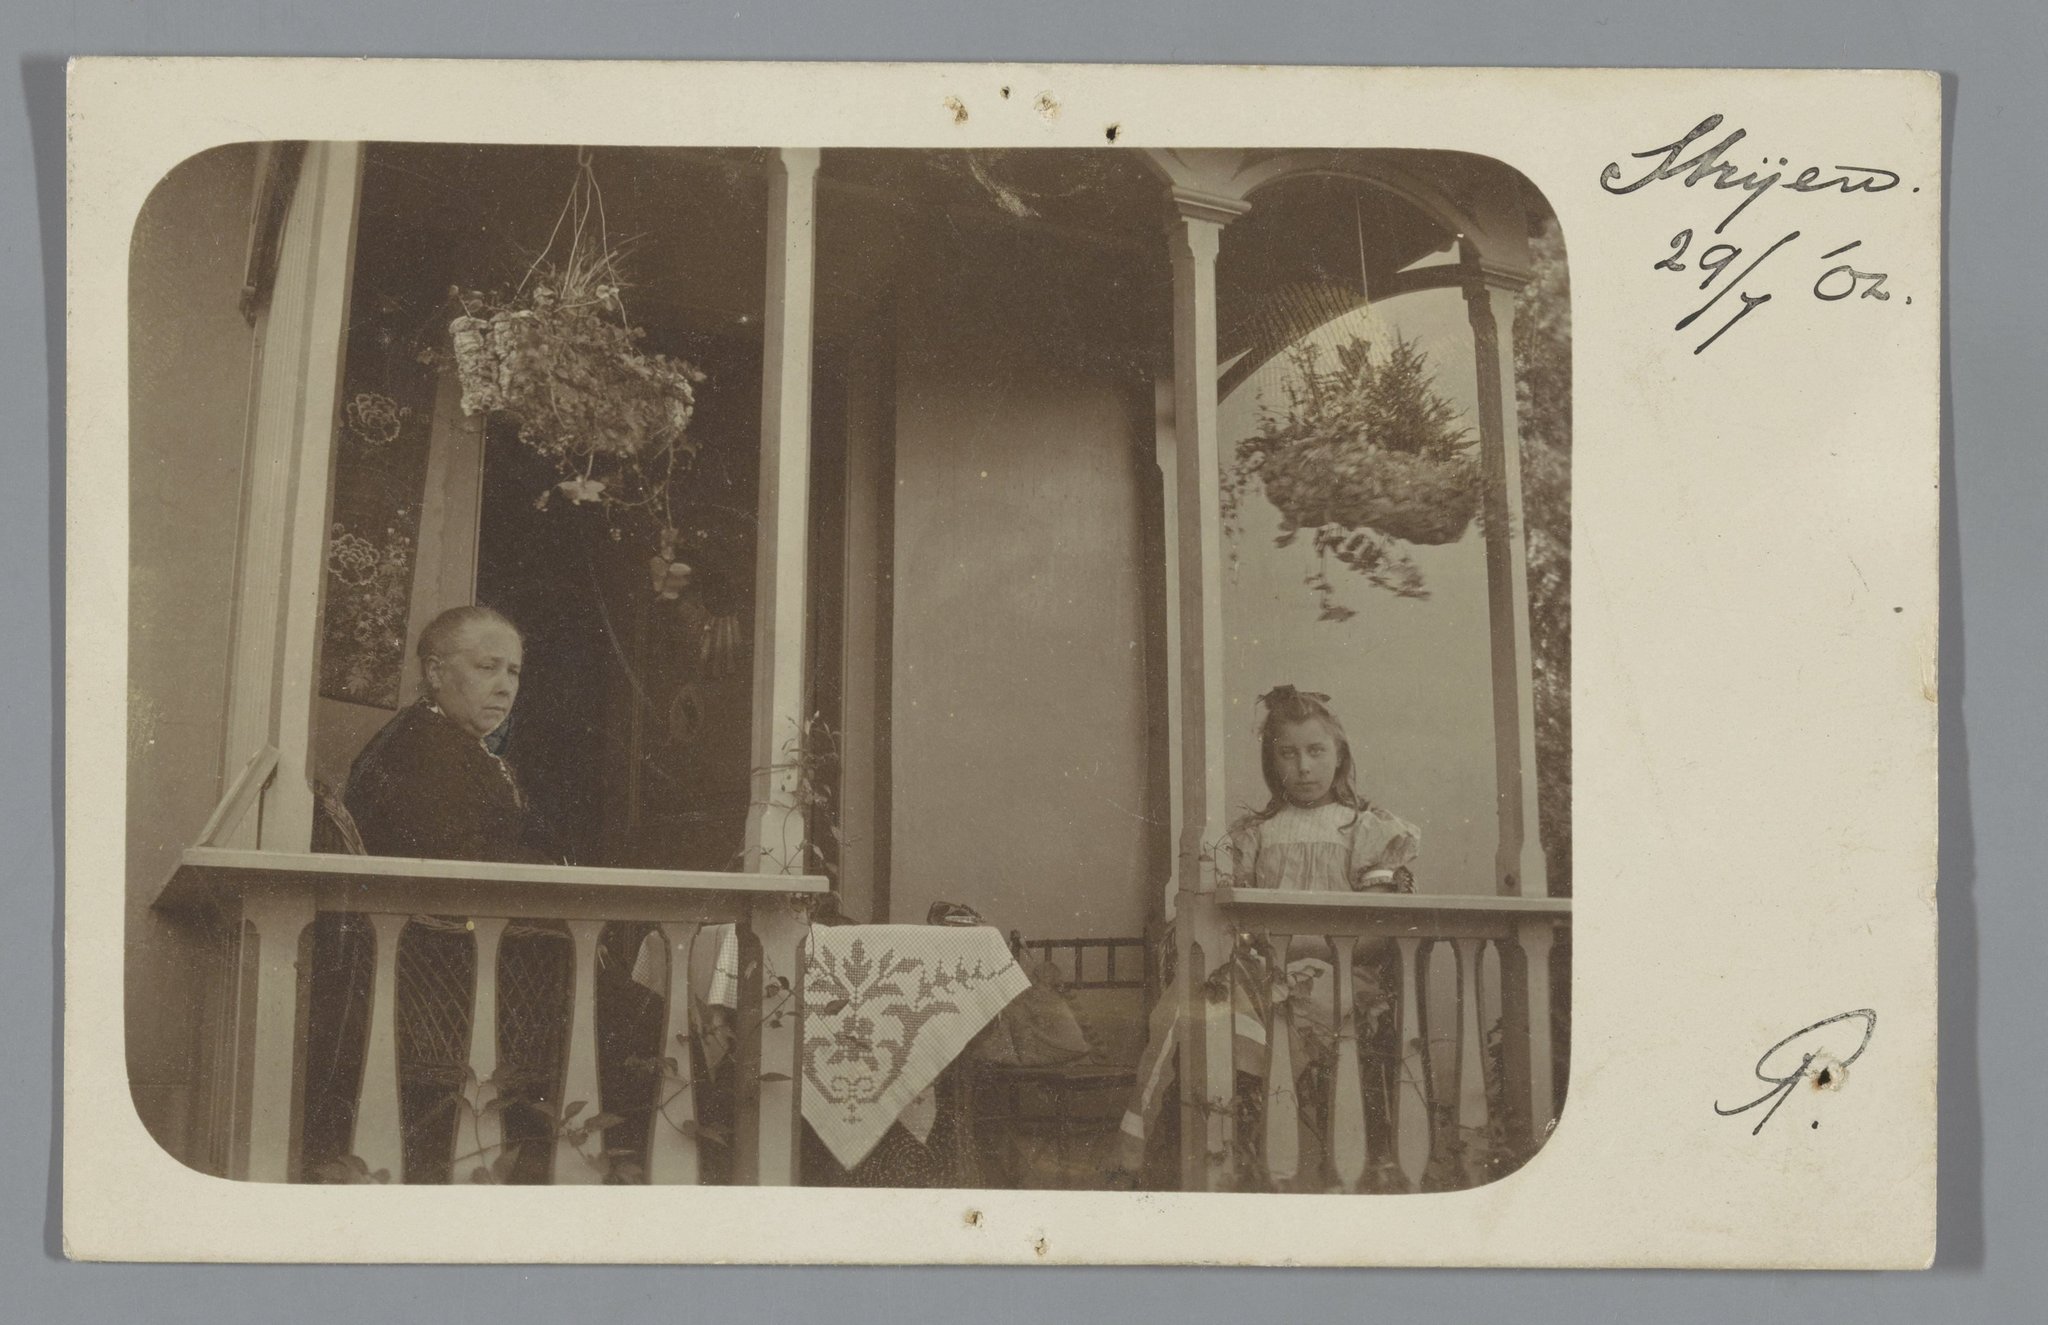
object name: photograph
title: Portret van een oude vrouw en een meisje op een veranda te Strijen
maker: Anonymous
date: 1902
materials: photographic support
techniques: gelatin silver print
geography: strijen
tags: girl (child between toddler and youth), old woman, loggia, verandah, porch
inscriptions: inscription: ‘Strijen 29/7 '02 P.’, inscription: ‘den Weled. Heer J. J. Honig Zaandijk’